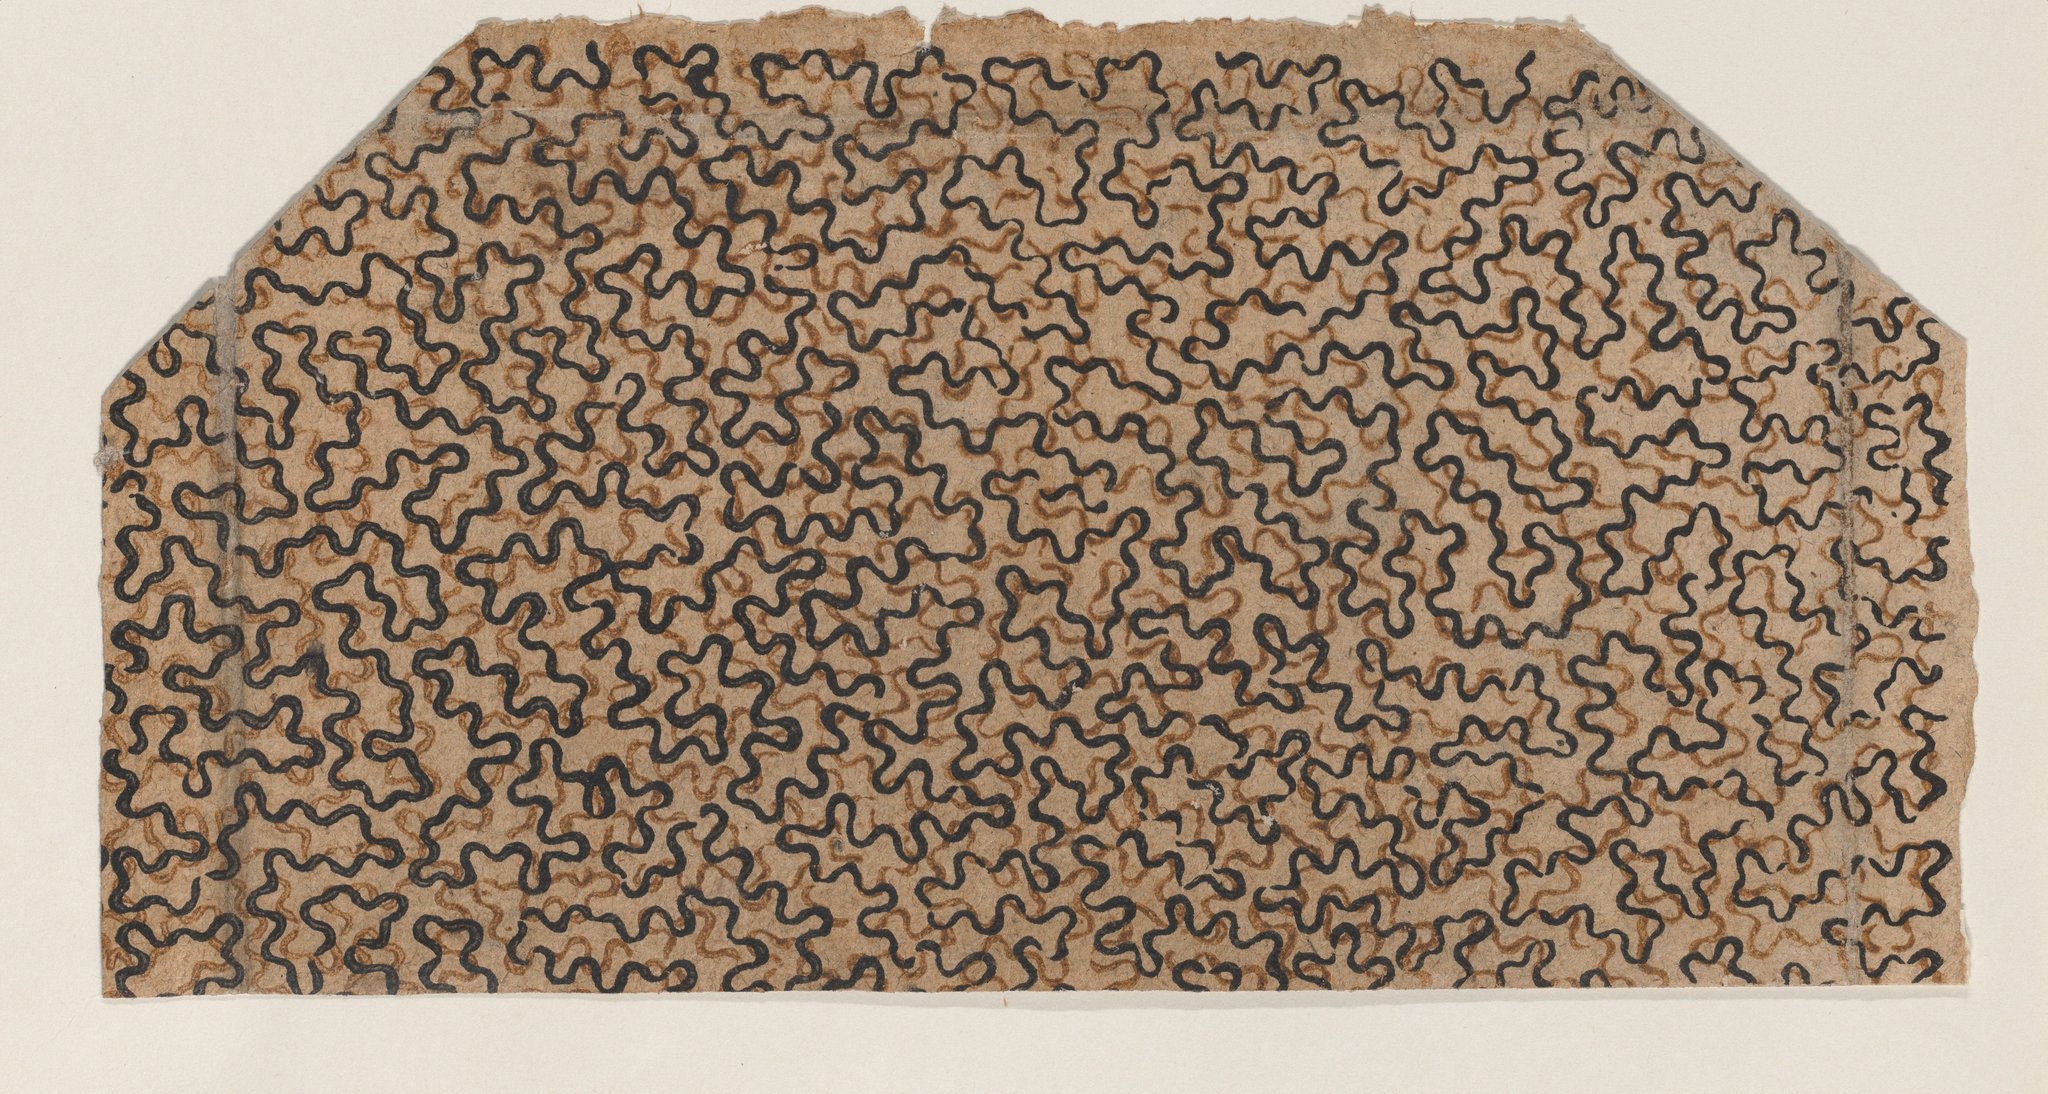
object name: print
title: Sheet with overall pattern of squiggly lines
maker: Anonymous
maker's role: artist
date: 1801-1900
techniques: relief print